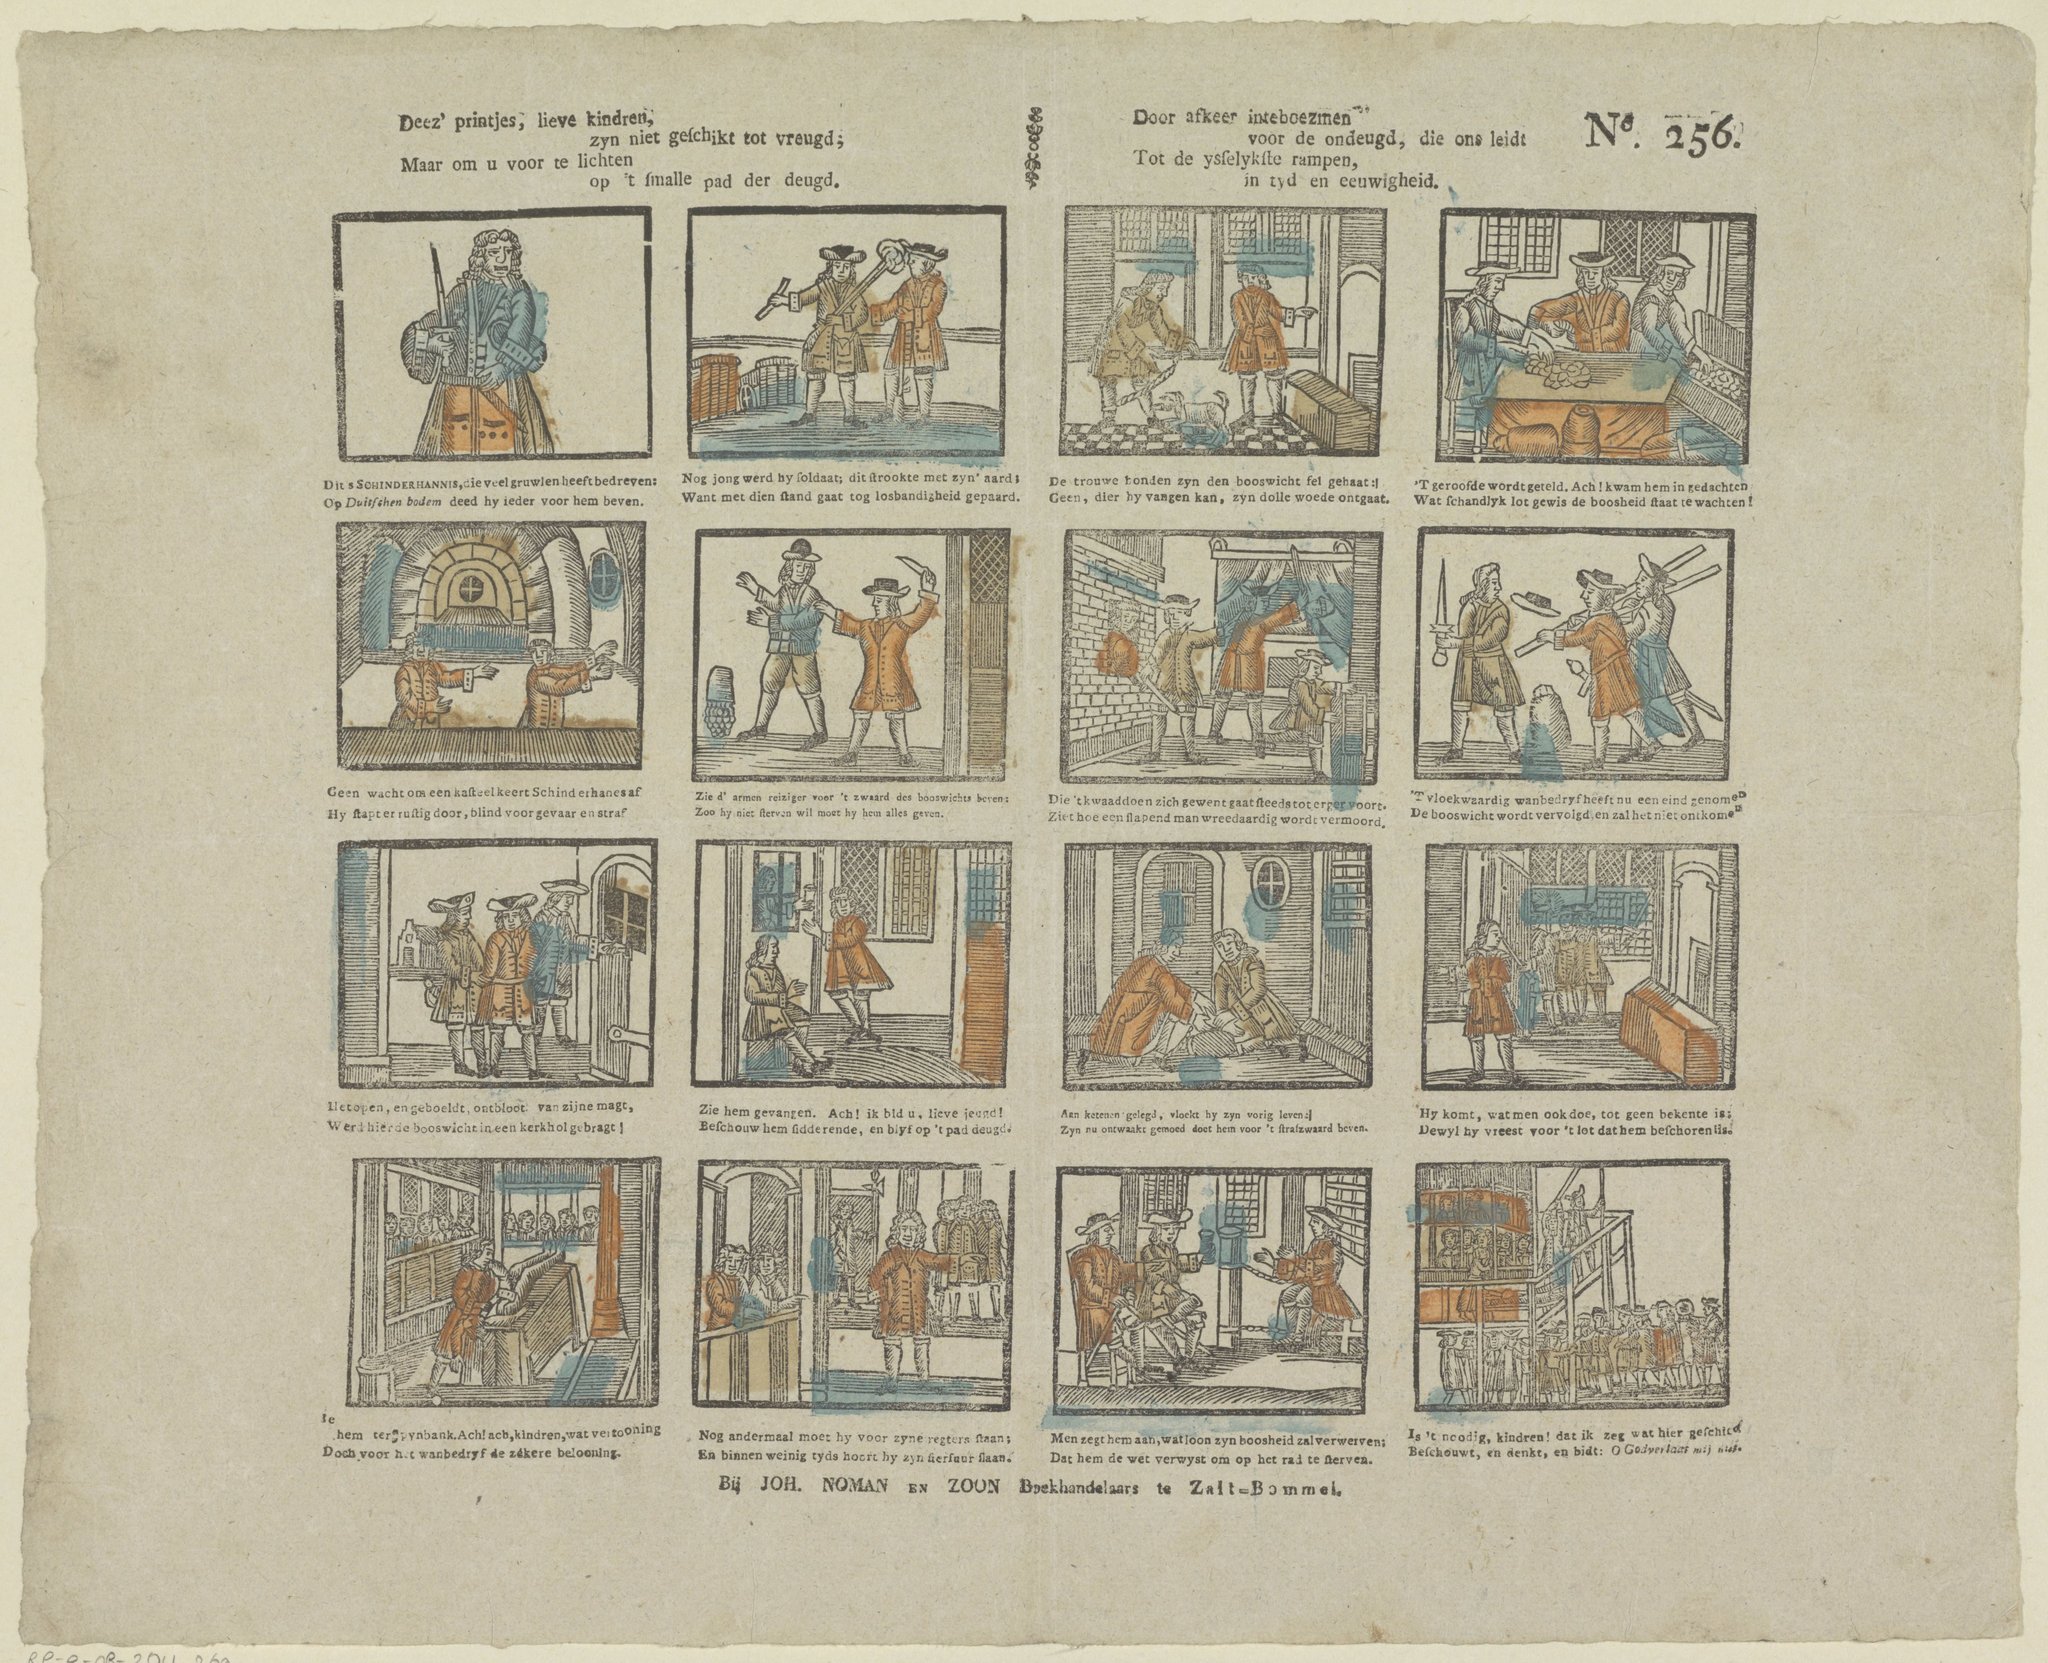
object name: print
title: Deez' printjes, lieve kindren, zyn niet geschikt tot vreugd, / Maar om u voor te lichten op 't smalle pad der deugd. / Door afkeer inteboezmen voor de ondeugd, die ons leidt / Tot de ysselykste rampen, in tyd en eeuwigheid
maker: Anonymous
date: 1830-1892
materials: paper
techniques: colour, letterpress printing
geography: zaltbommel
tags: tales and fairy tales, the soldier; the soldier's life, imprisonment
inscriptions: collector's mark: Lugt 2760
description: Blad met 16 voorstellingen over het leven en avonturen van Schinderhannes, de Duitse tegenhanger van Cartouche. Onder elke afbeelding een tweeregelig vers. Genummerd rechtsboven: No. 256.